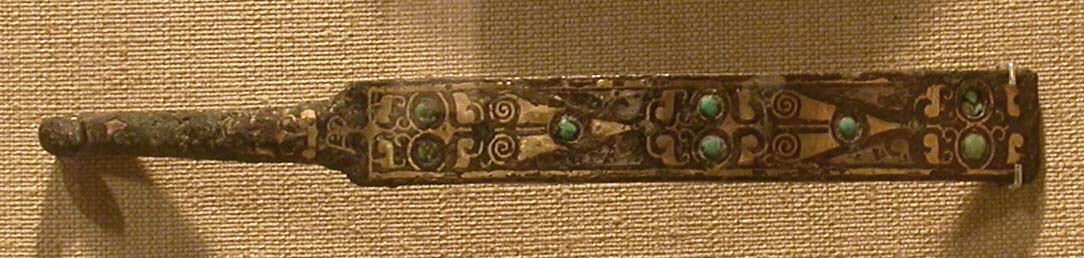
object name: belt hook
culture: chinese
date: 400-101 BCE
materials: bronze, gold, silver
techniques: inlay